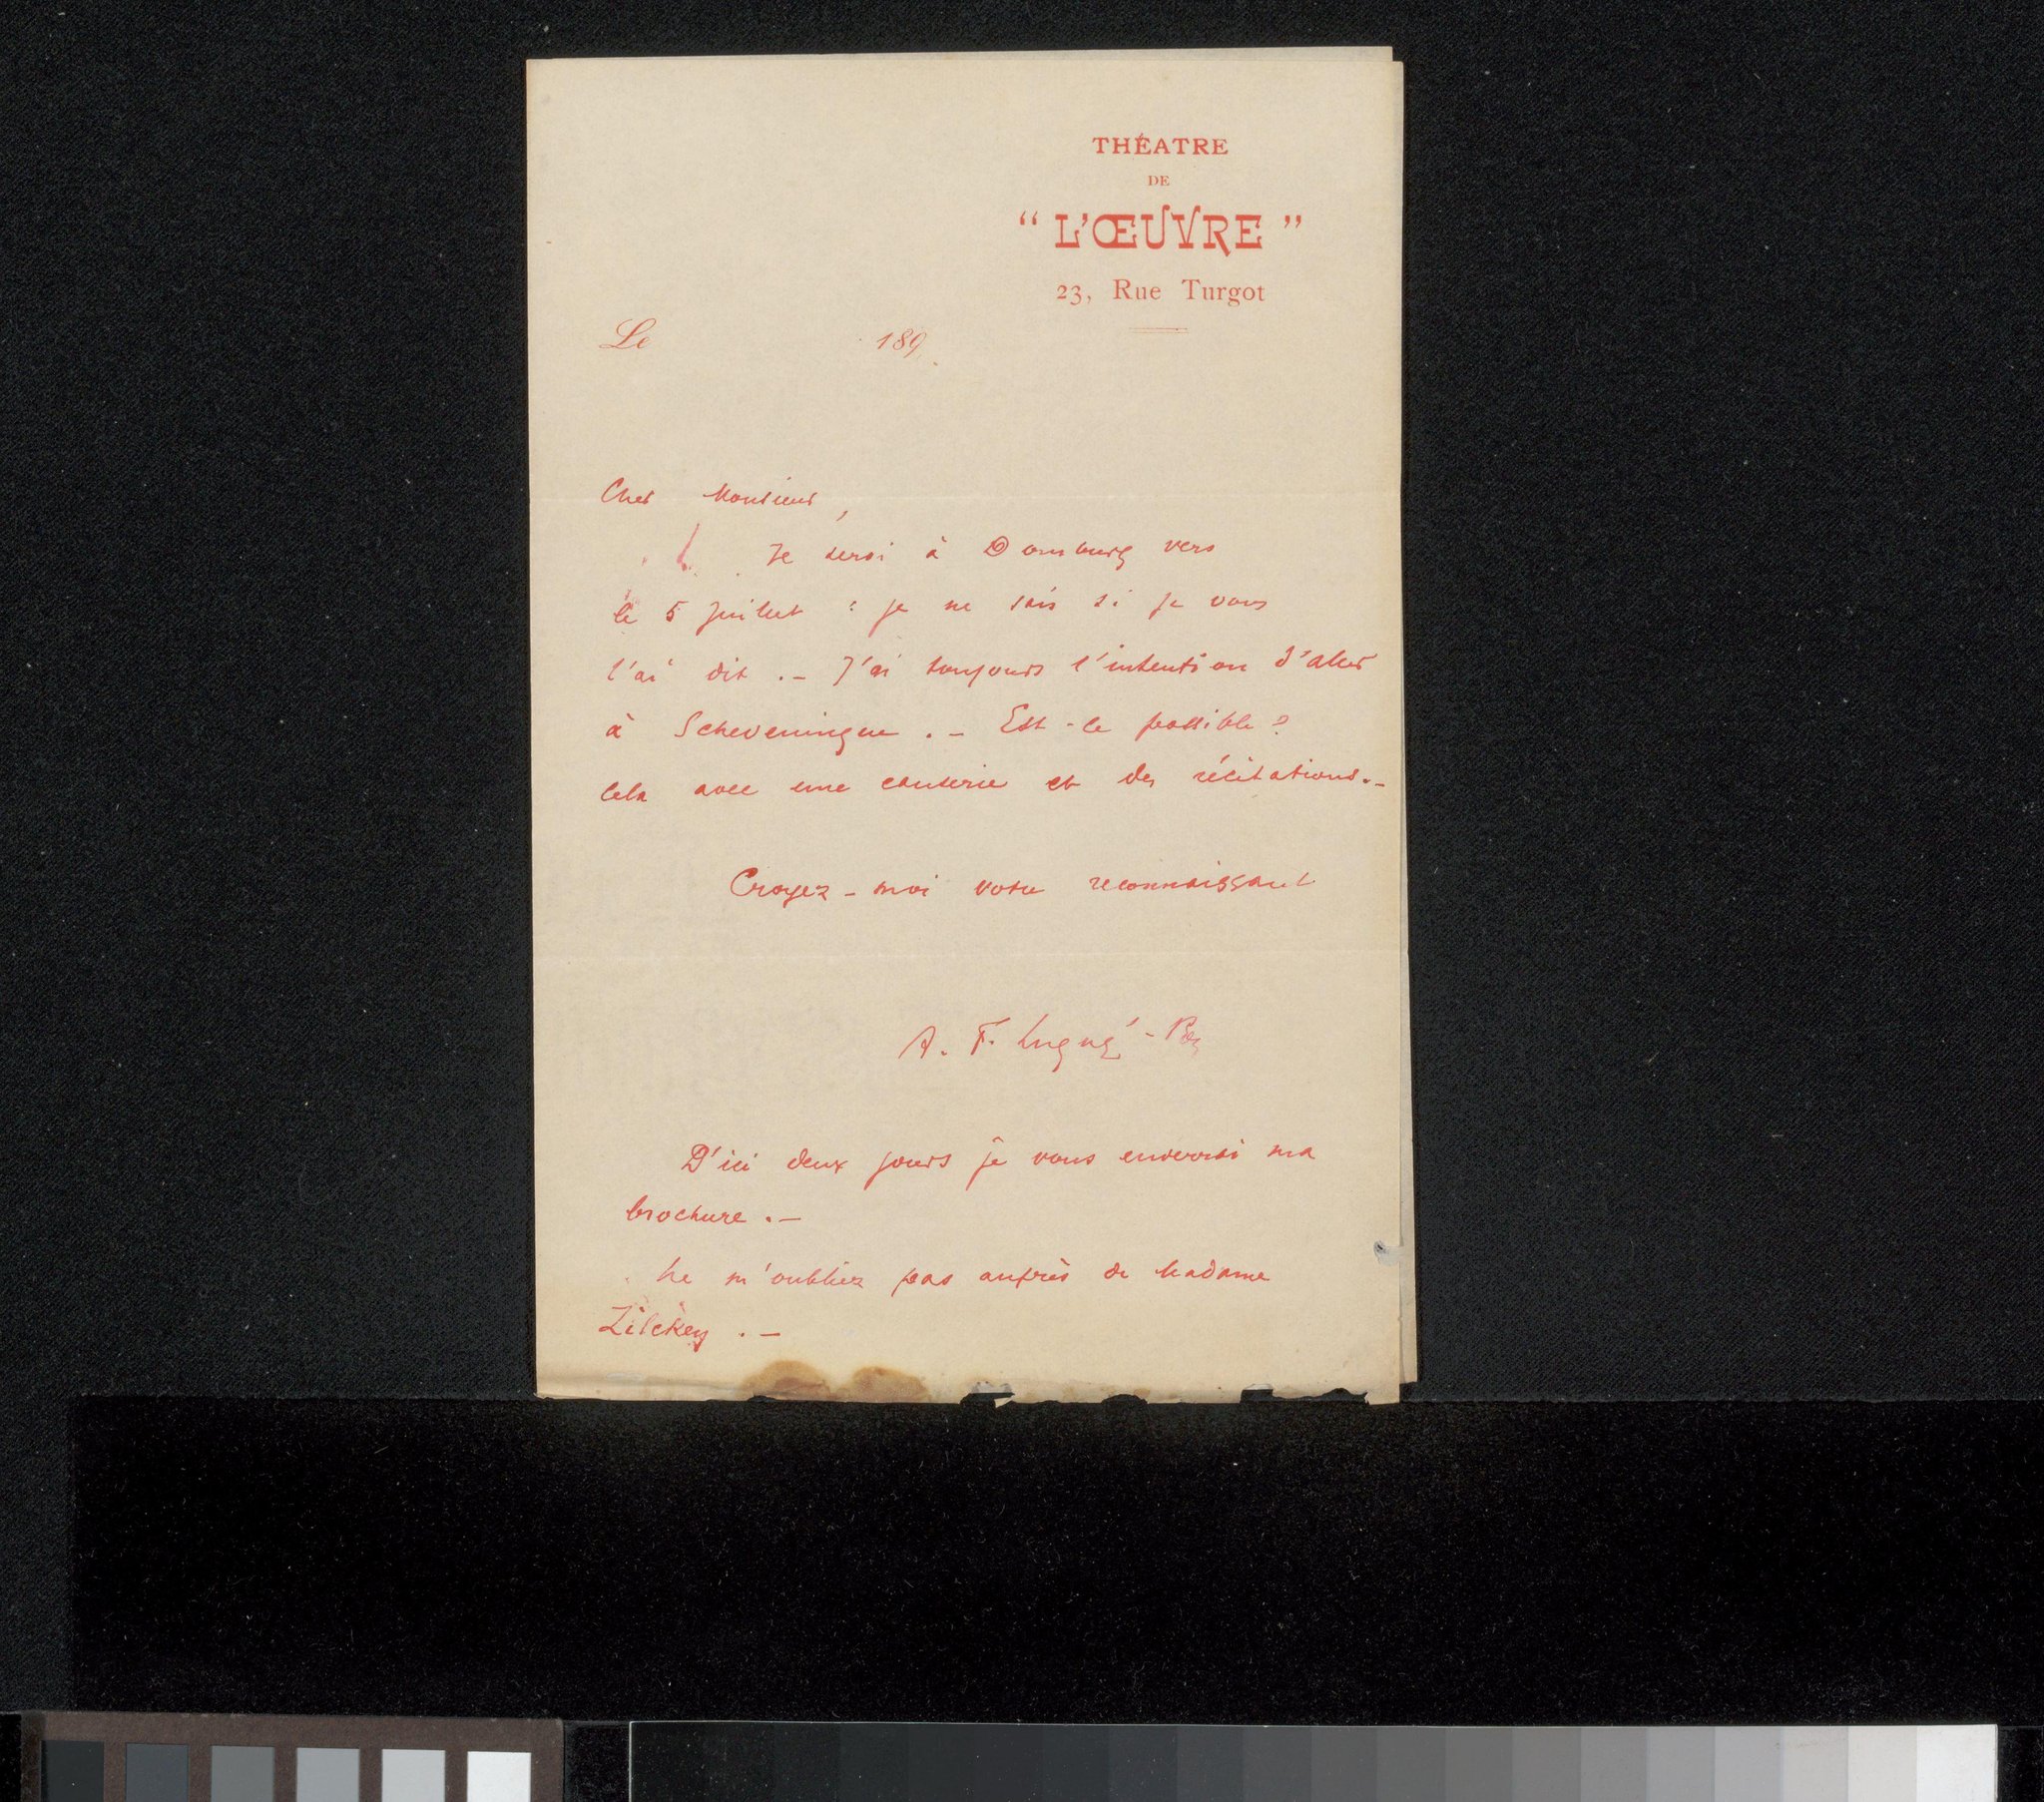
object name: letter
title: Brief aan Philip Zilcken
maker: lugné-poe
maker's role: acteur, theaterdirecteur, theatervormgever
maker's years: 1869-1940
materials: ink, paper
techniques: pen, printing, writing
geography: paris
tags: painter, draughtsman, philip zilcken, printed matter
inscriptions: watermark, collector's mark: ‘RPK’